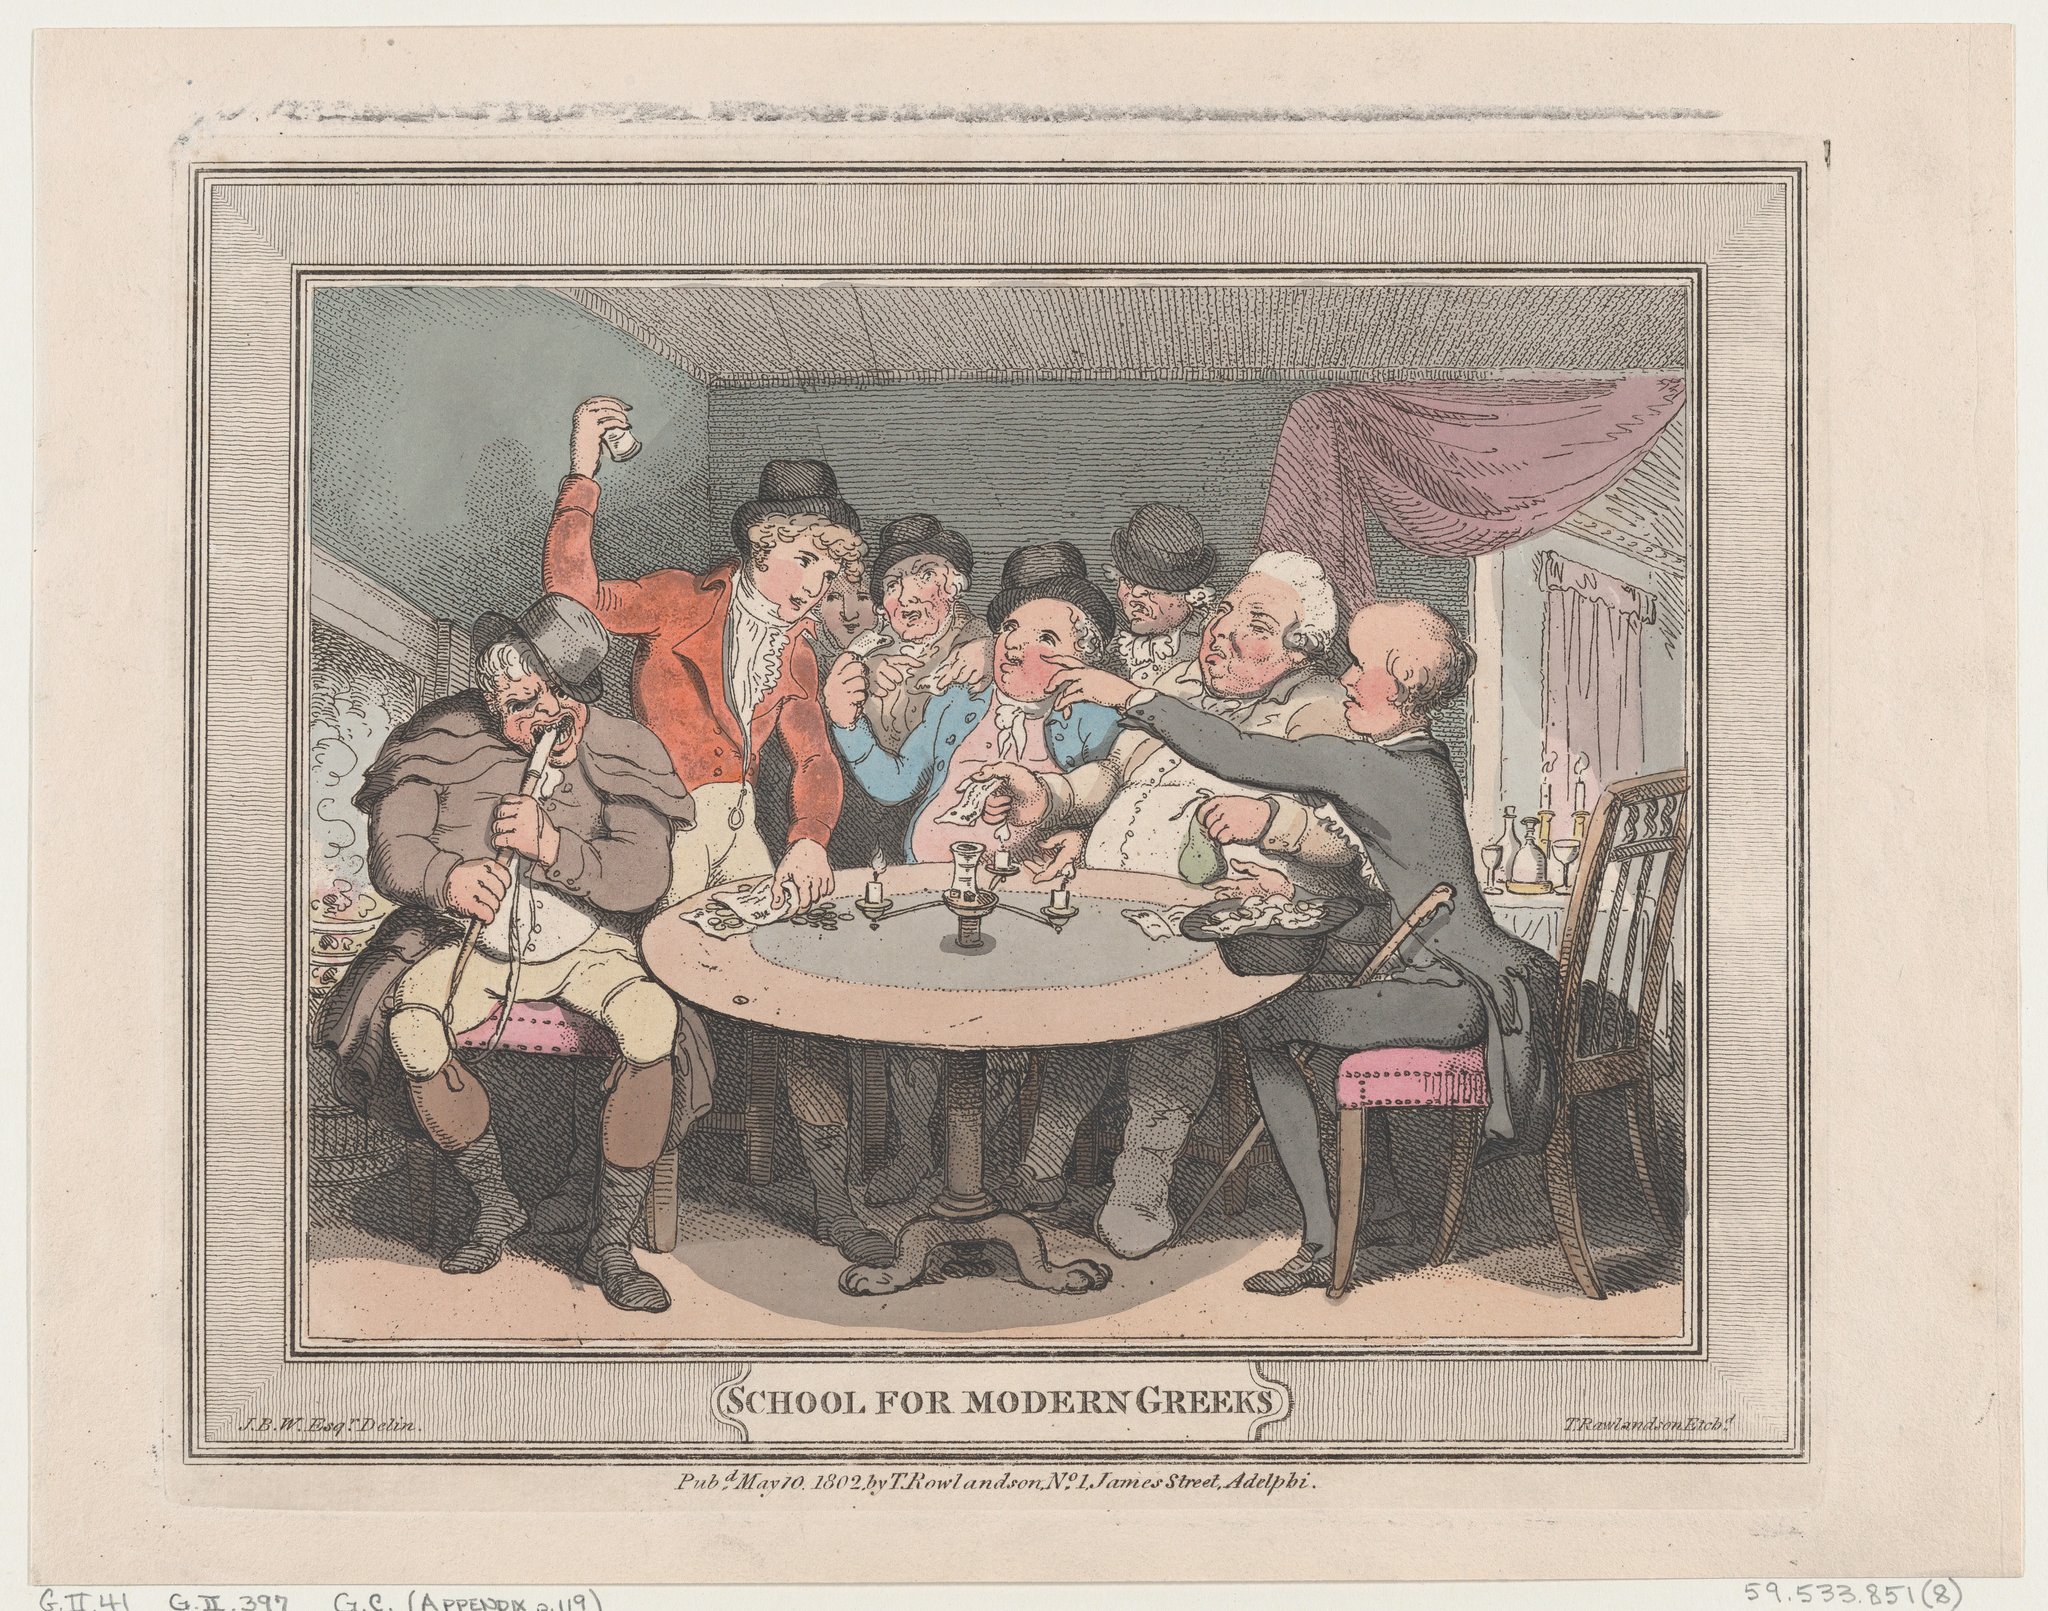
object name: print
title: School for Modern Greeks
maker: thomas rowlandson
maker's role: artist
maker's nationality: british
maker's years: 1757-1827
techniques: etching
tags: satire,men